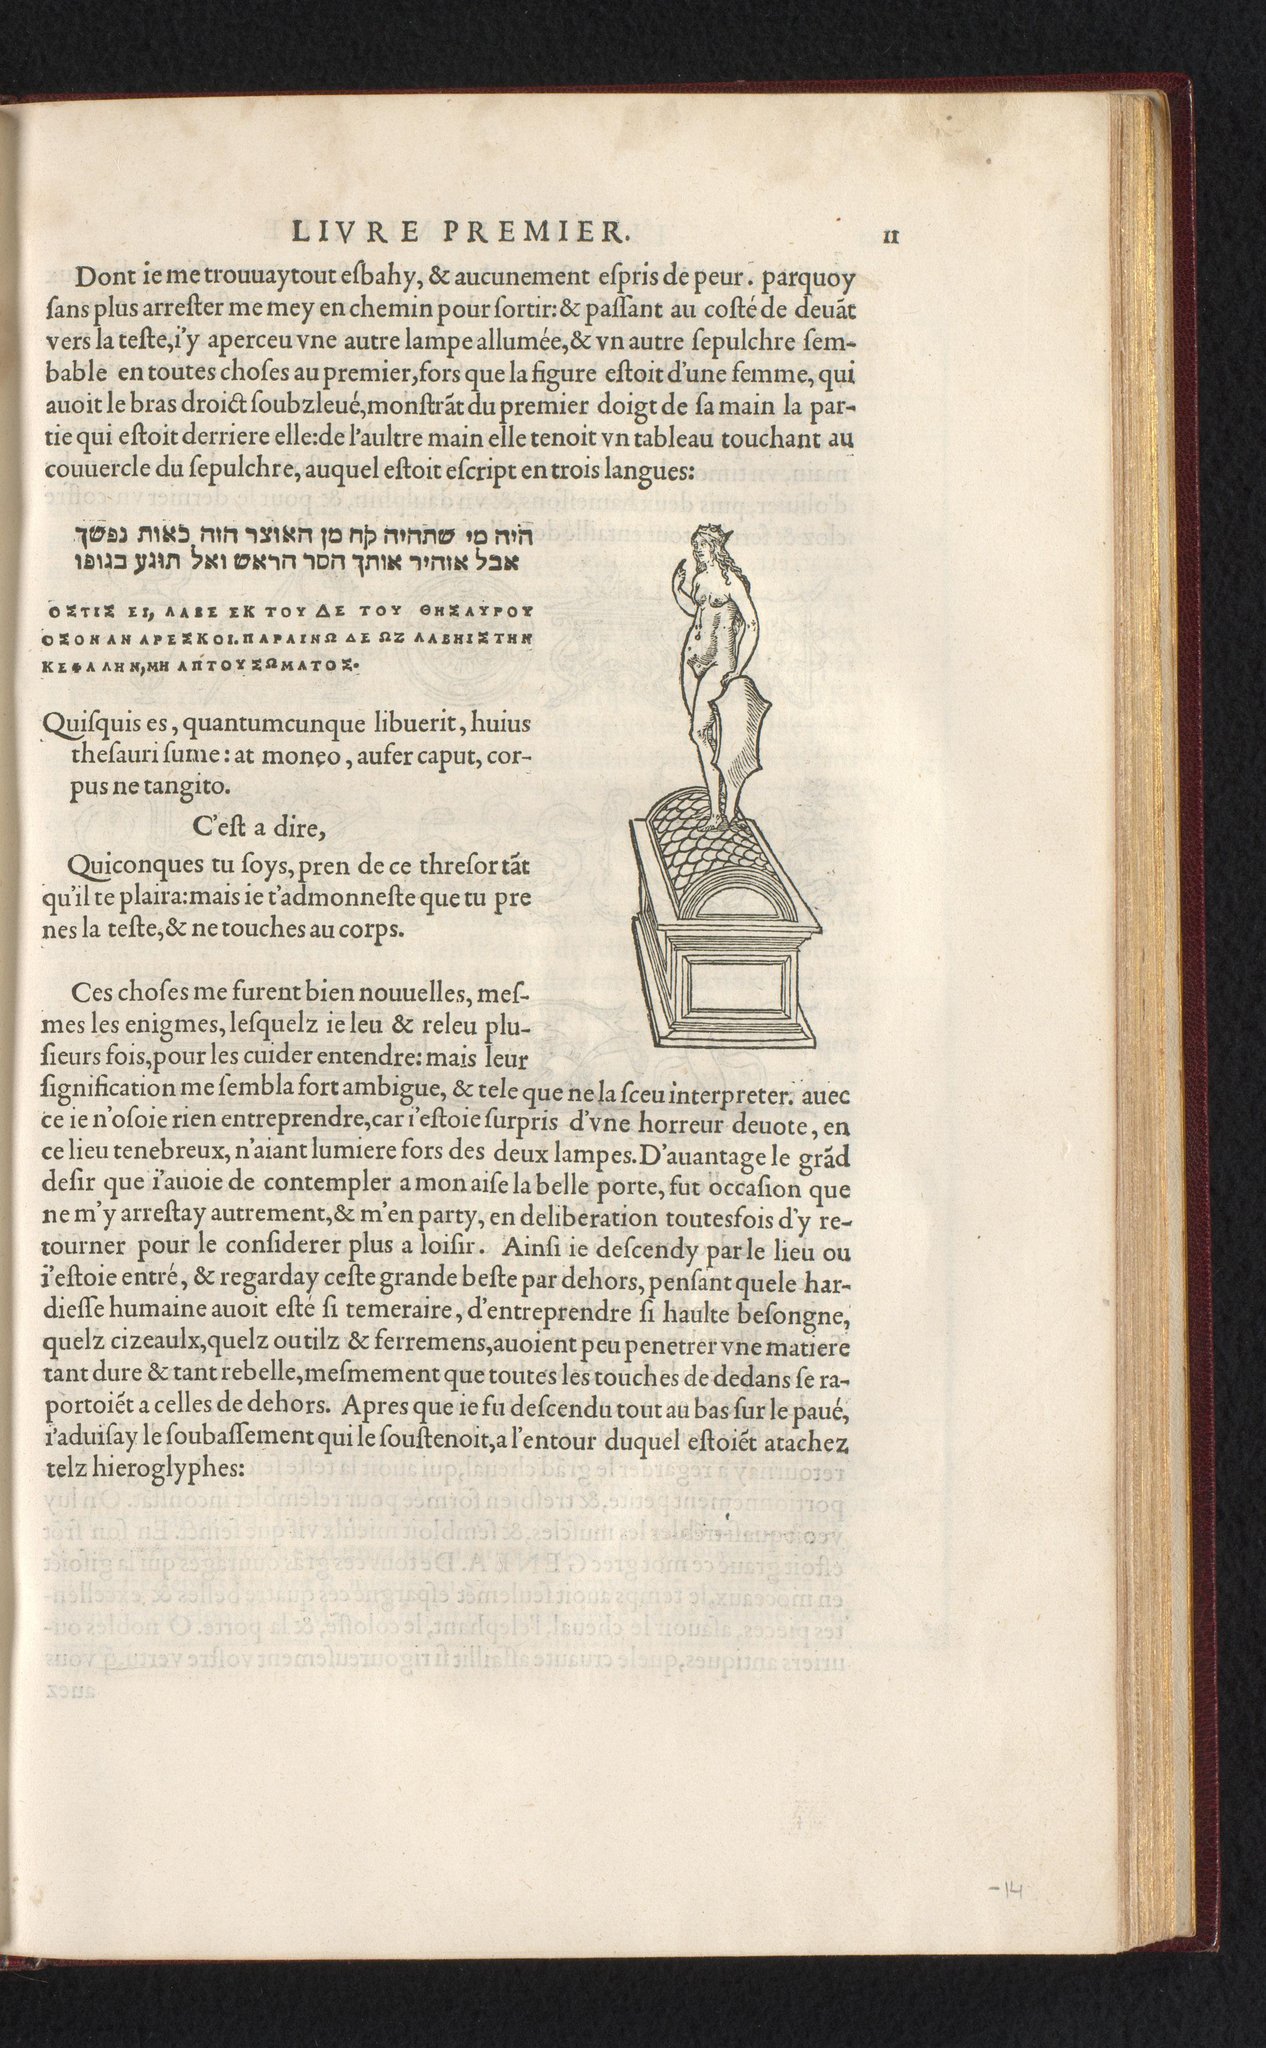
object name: print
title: Standbeeld van een naakte vrouw met kroon en schild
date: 1546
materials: paper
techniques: letterpress printing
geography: paris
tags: (scenes from) specific works of literature: colonna, hypnerotomachia poliphili, monument, statue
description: Prent uit: Colonna, Francesco. Hypnerotomachie ou discours du songe de Poliphile, deduisant comme amour le combat a l'occasion de Polia. Parijs: Jacques Kerver, 1546, recto fol. 11.